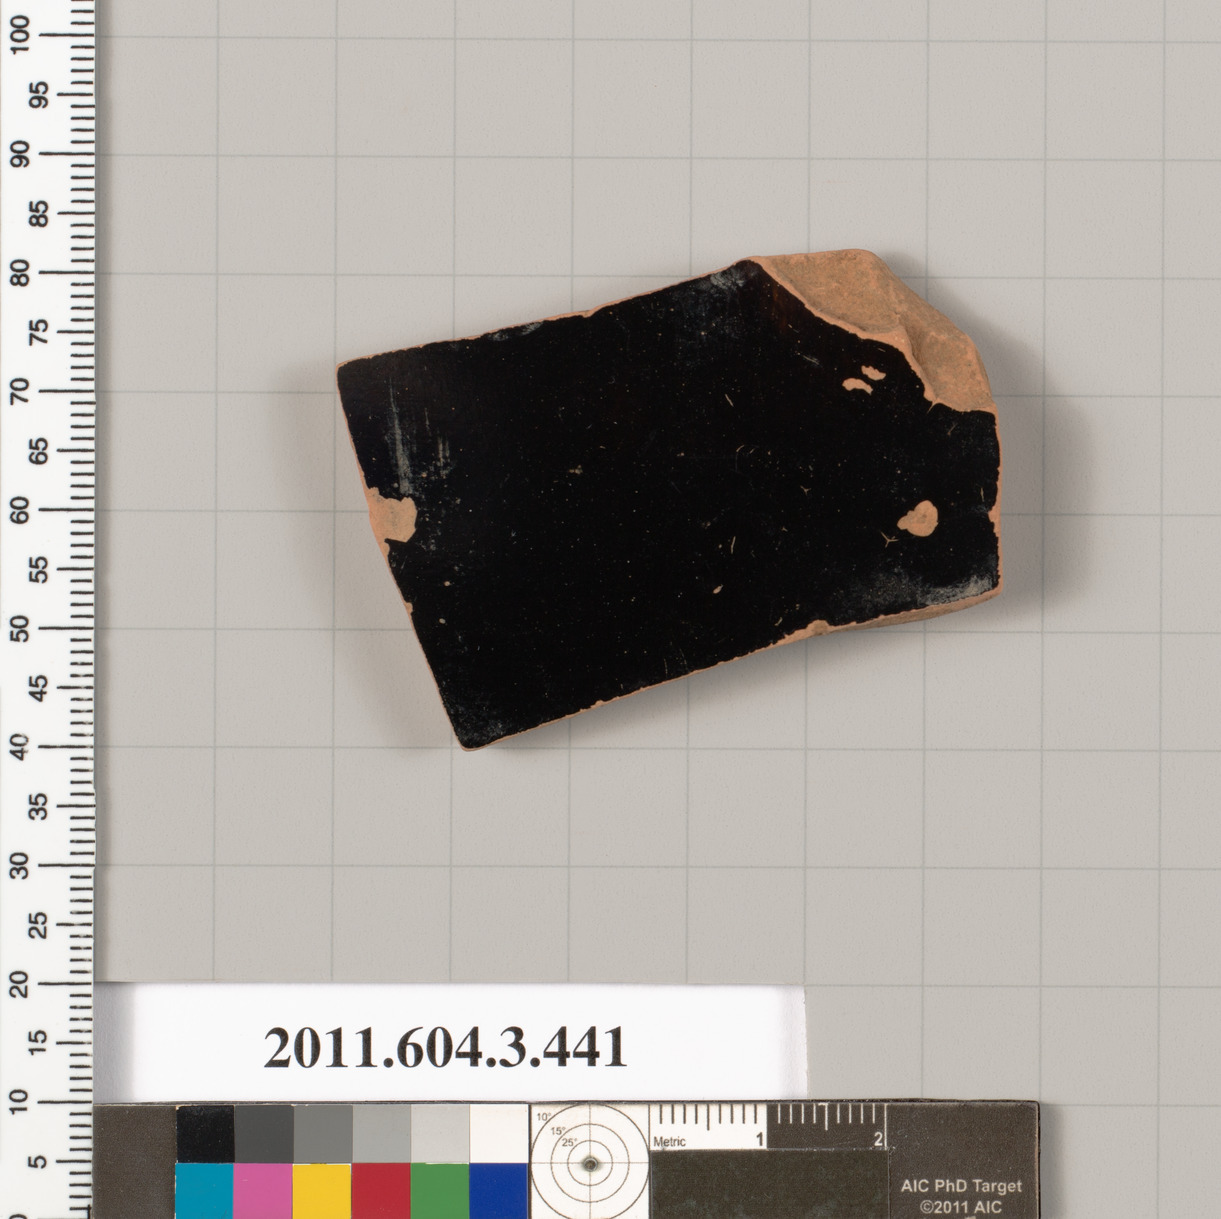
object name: neck amphora fragment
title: Terracotta fragment of a neck-amphora (jar)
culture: greek, attic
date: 600-401 BCE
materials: terracotta